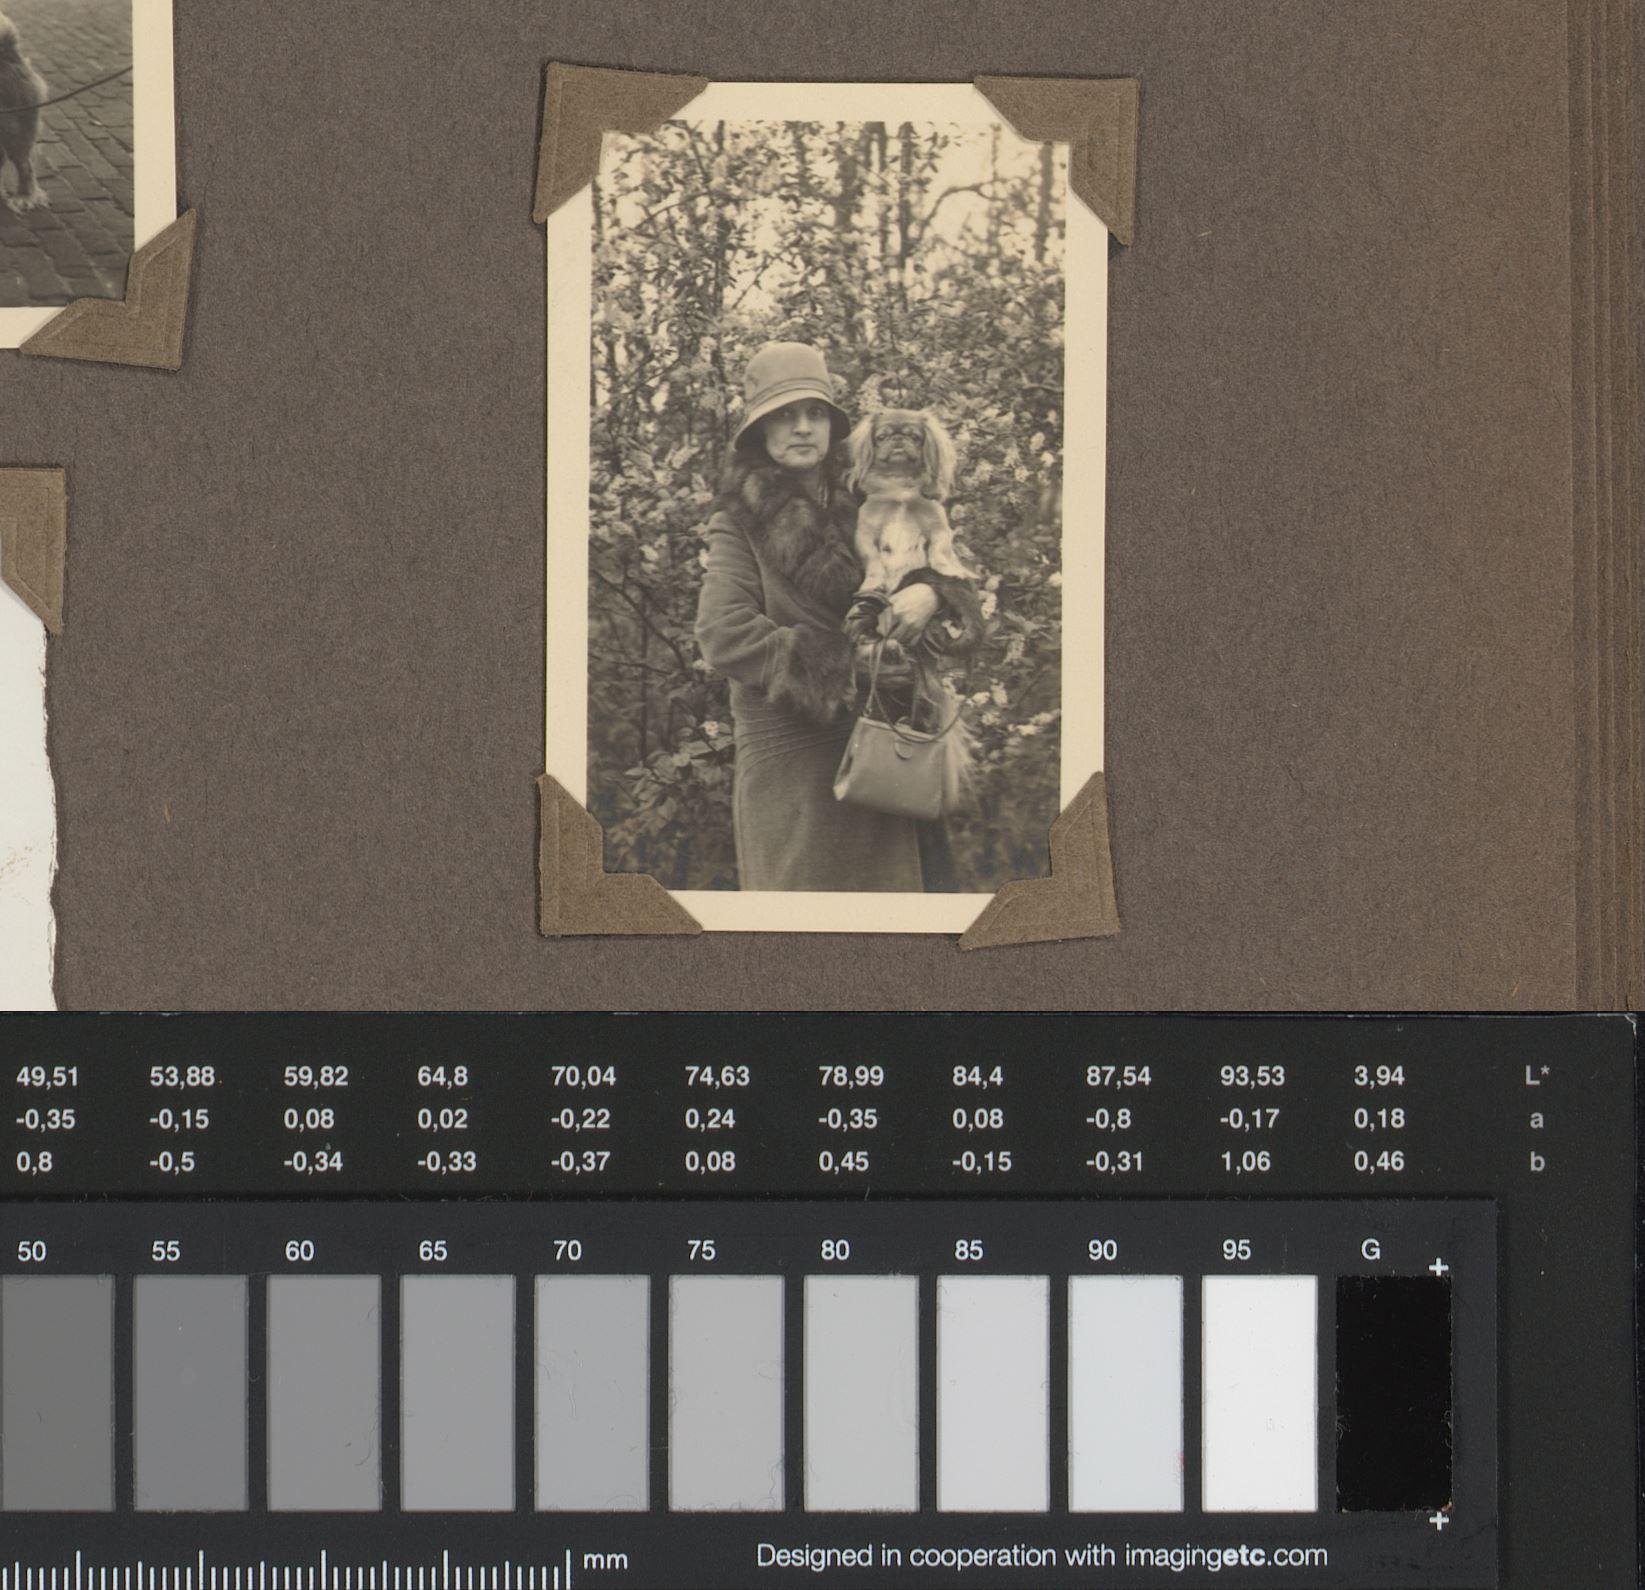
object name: album leaf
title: Portret van Henriëtte Wassink met een hond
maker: Anonymous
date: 1930-1935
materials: paper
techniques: gelatin silver print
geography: netherlands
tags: batavia, henriëtte wassink, adult woman, historical persons - bb - woman, dog, netherlands